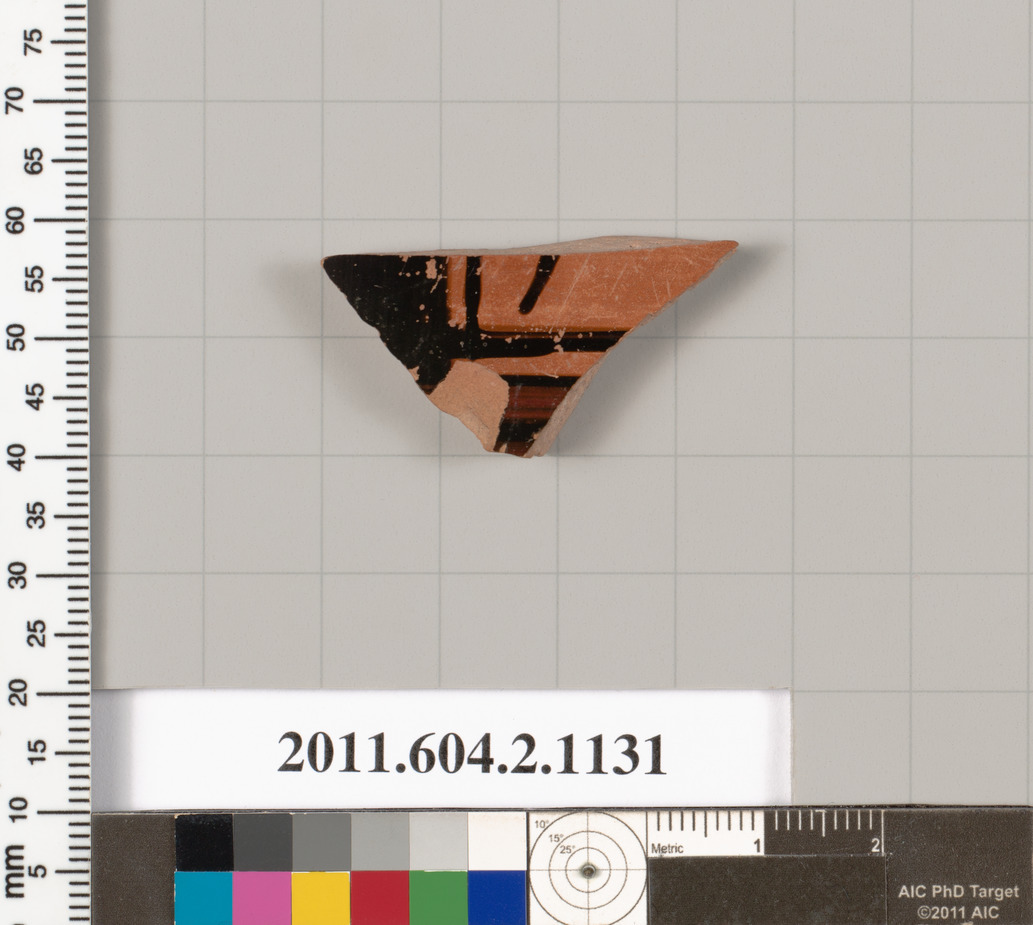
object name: lekythos fragment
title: Terracotta fragment of a lekythos (oil flask)?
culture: greek, attic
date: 460-440 BCE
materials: terracotta